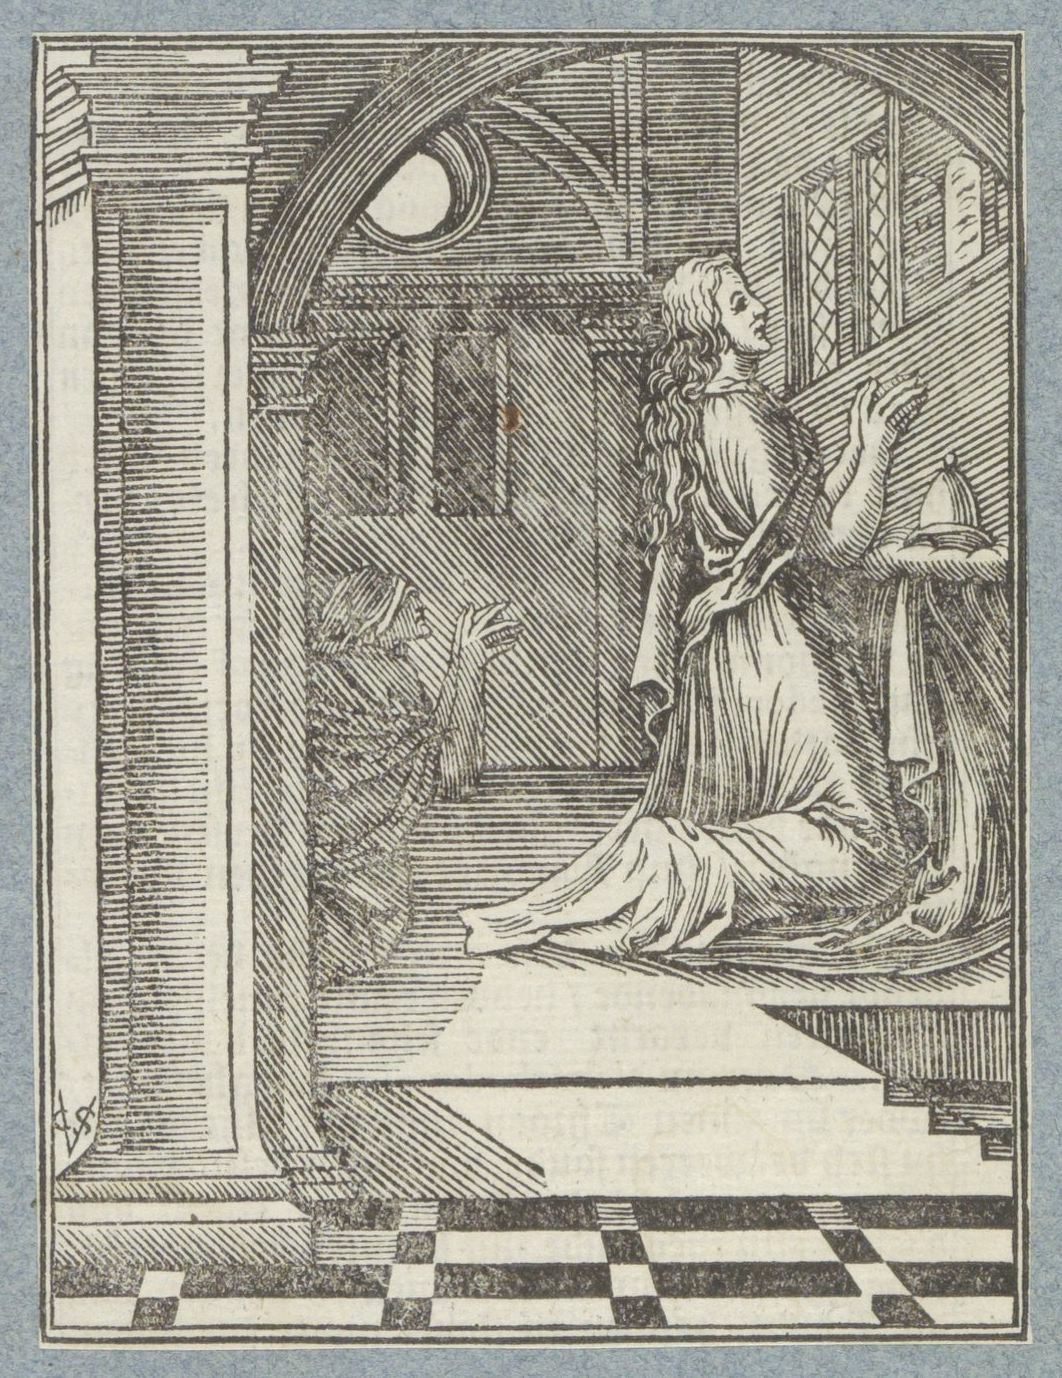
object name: album leaf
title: Judits gebed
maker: pieter jacobsz. paets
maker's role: publisher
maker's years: 1587-1667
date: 1645-1646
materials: paper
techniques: letterpress printing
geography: amsterdam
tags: mourning, prayer and distress of esther (esther 14), judith's prayer ~ judith and holofernes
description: De figuur van de biddende vrouw is gekopieerd naar een detail in een prent van Philips Galle naar ontwerp van Maarten van Heemskerck. De prent werd gemaakt voor de uitgaven van P.J. Paets uit Amsterdam. Ze komt in ieder geval voor in: Bibels Tresoor ofte der zielen lusthof. Amsterdam, P.J. Paets, 1646. Mogelijk ook in: Historien ende Prophetien. [Amsterdam], P.J. Paets, 1645.